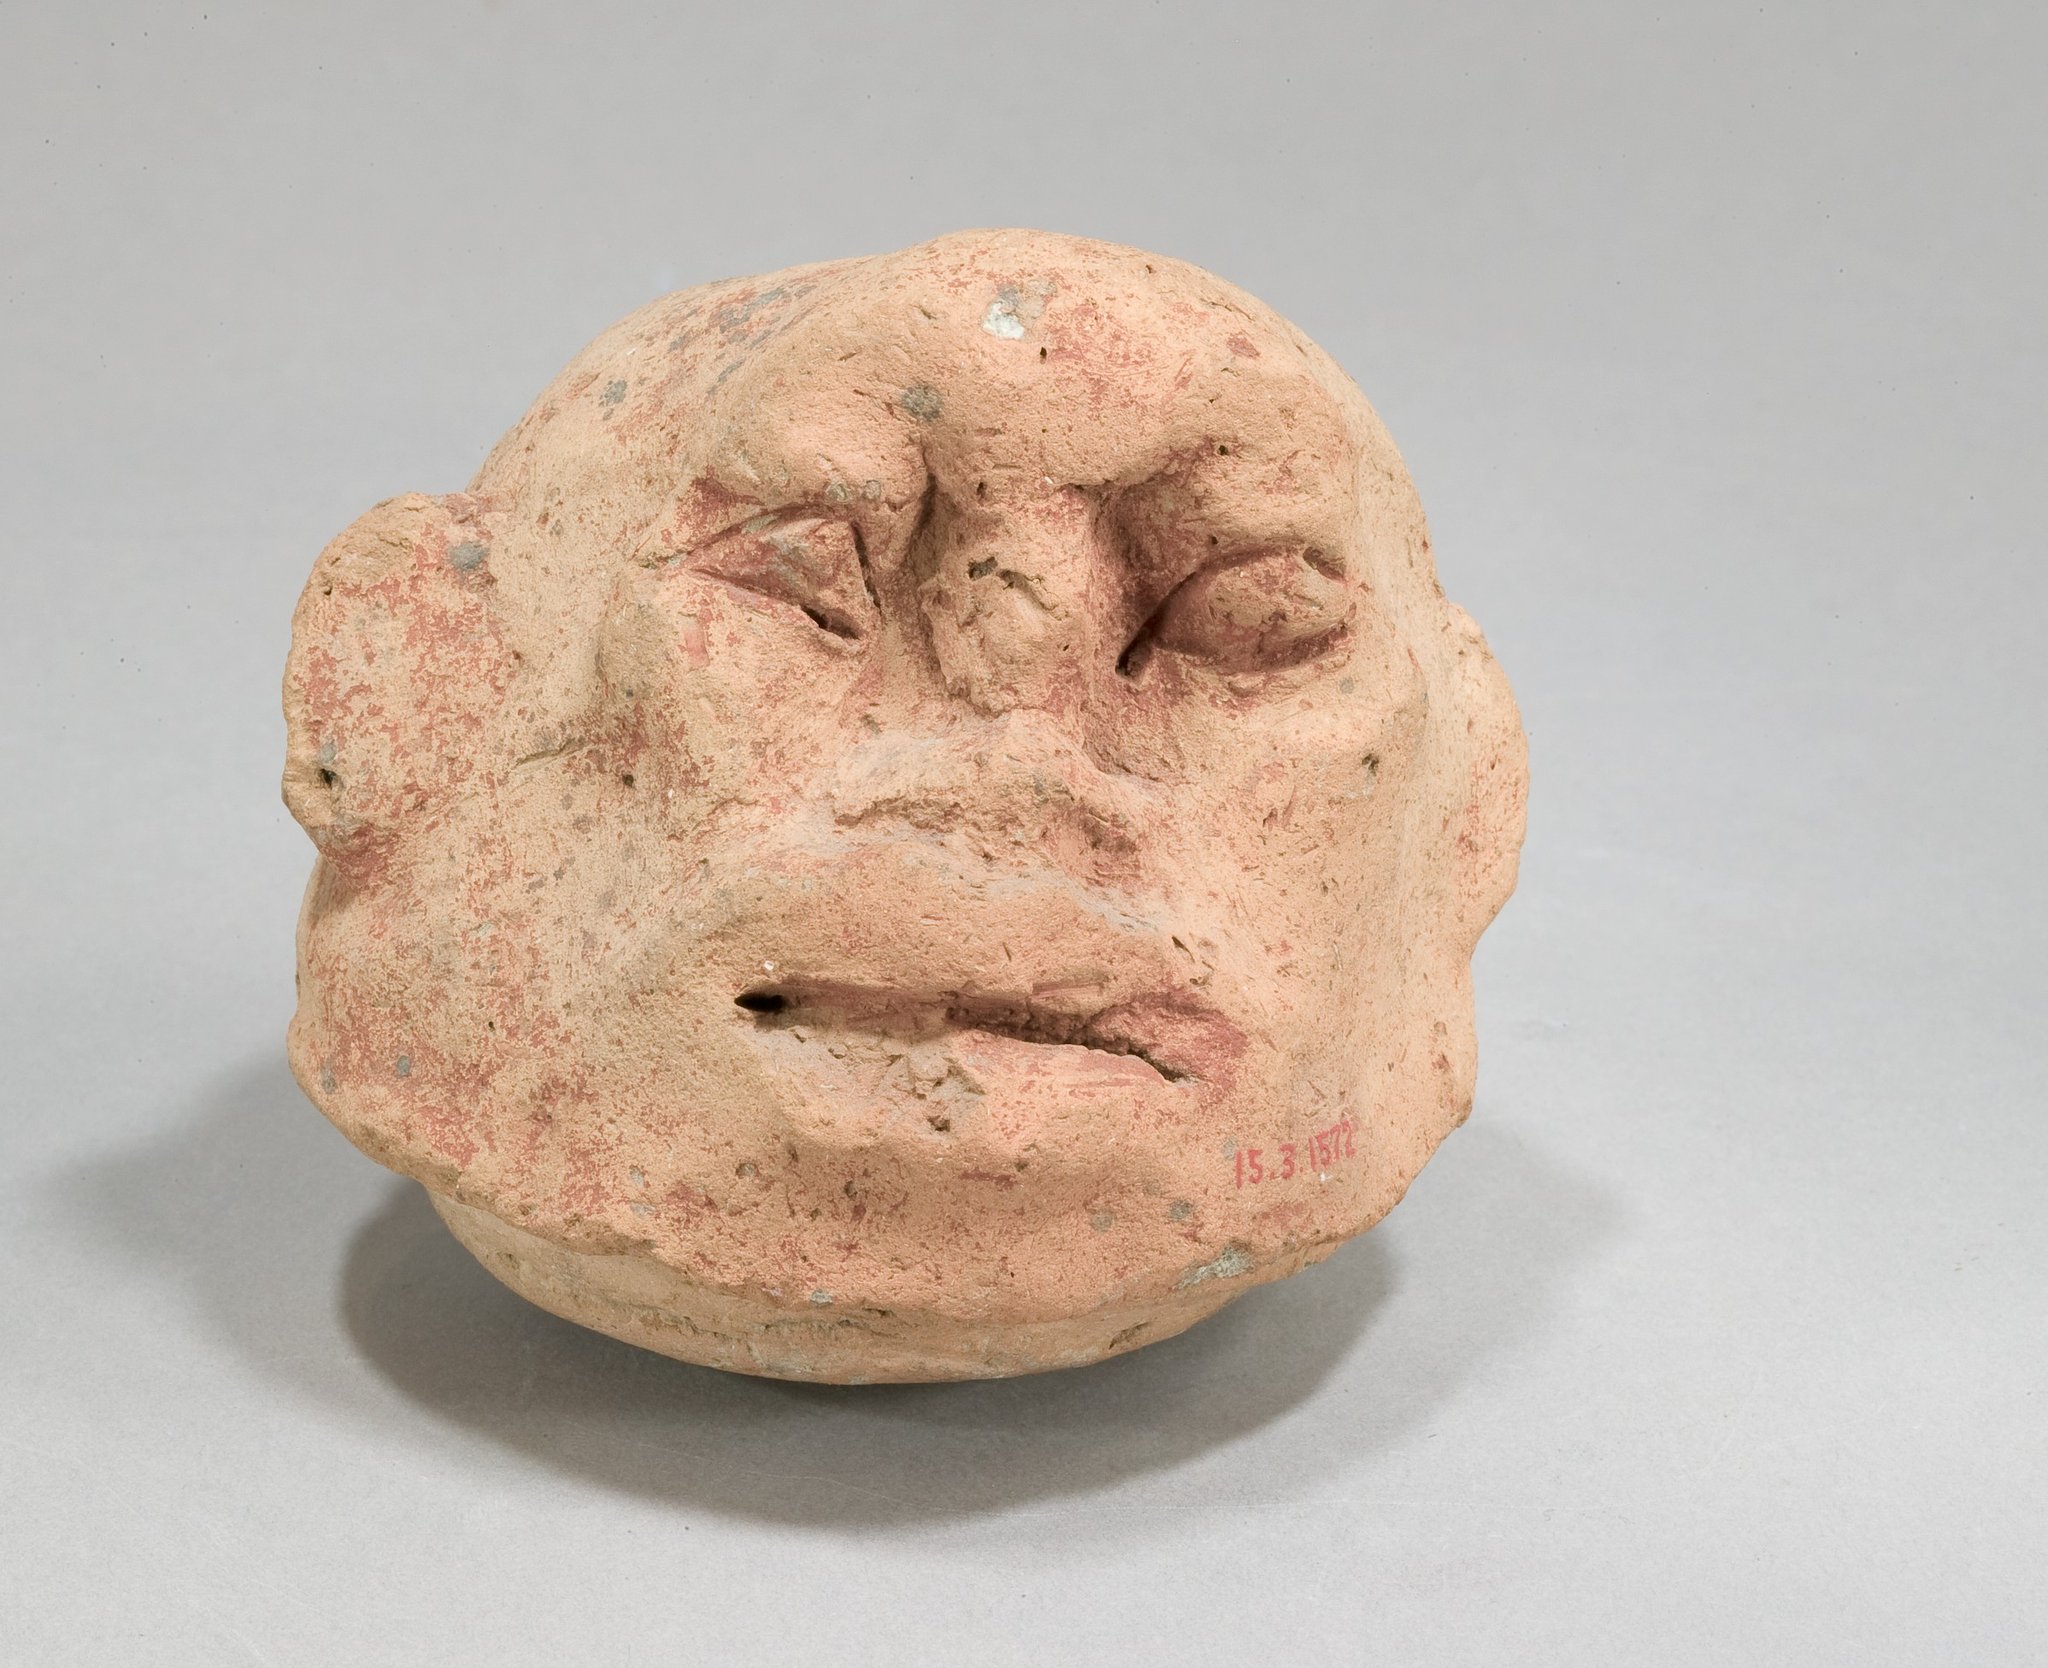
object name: lid of vessel, grotesque head be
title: Lid of vessel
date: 1981-1640 BCE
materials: pottery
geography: egypt